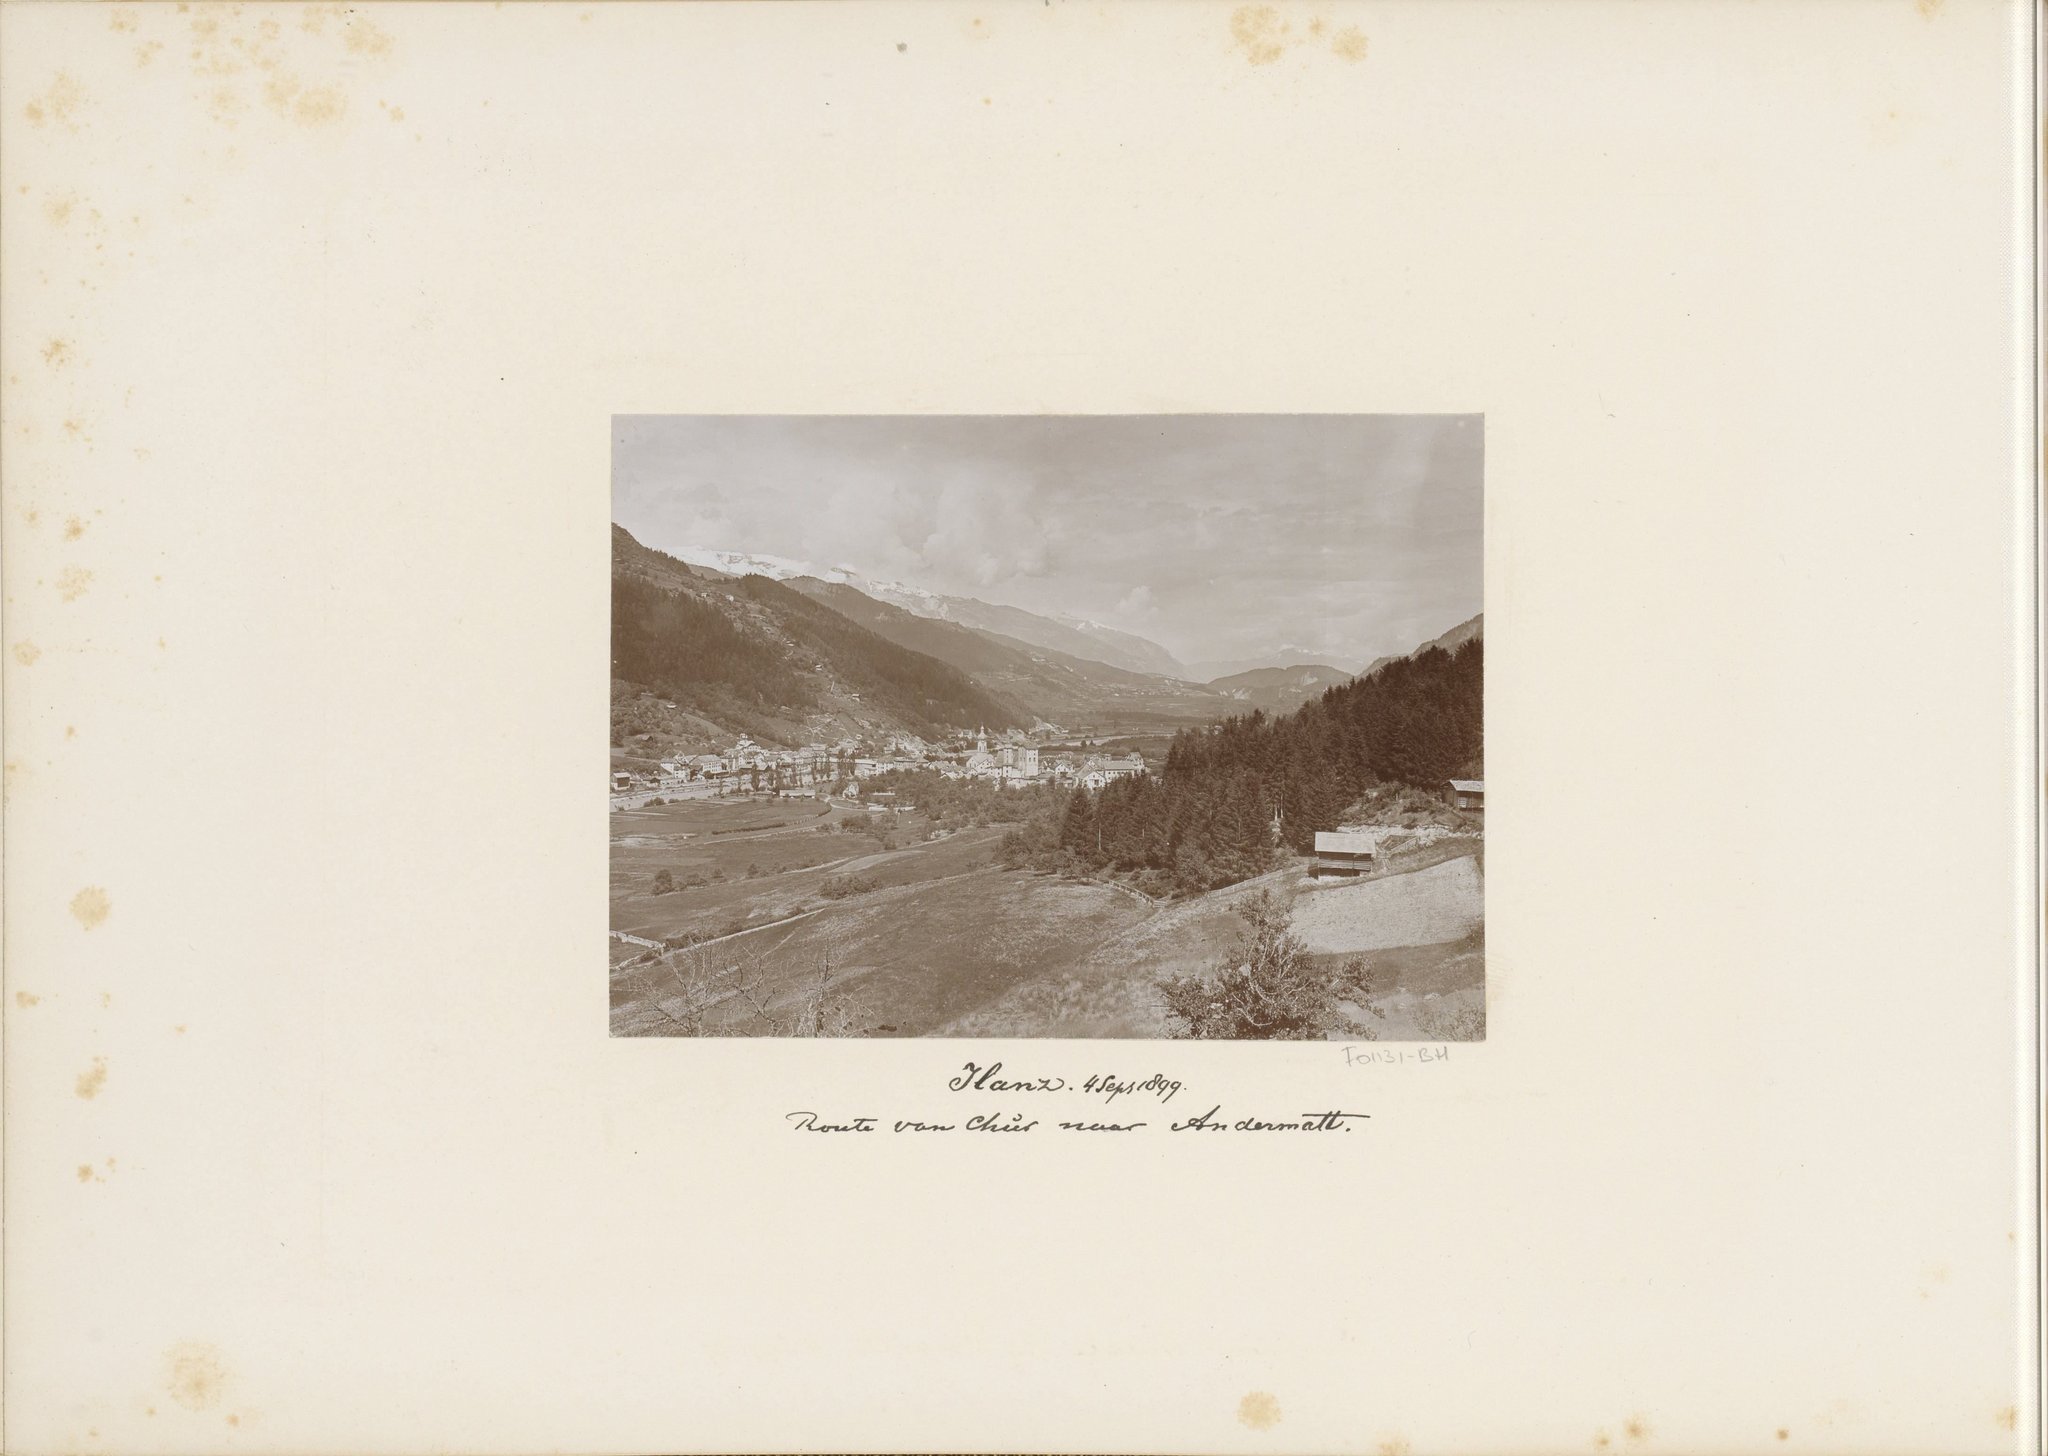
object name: photograph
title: Gezicht op Hanz op de route van Chur naar Andermatt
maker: Anonymous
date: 1880-1899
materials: paper, photographic support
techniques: collodion silver print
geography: switzerland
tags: prospect of village, silhouette of village, mountains (+ landscape with figures, staffage), switzerland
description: Onderdeel van Reisalbum met bezienswaardigheden in Duitsland, Oostenrijk, Zwitserland, Luxemburg en België.